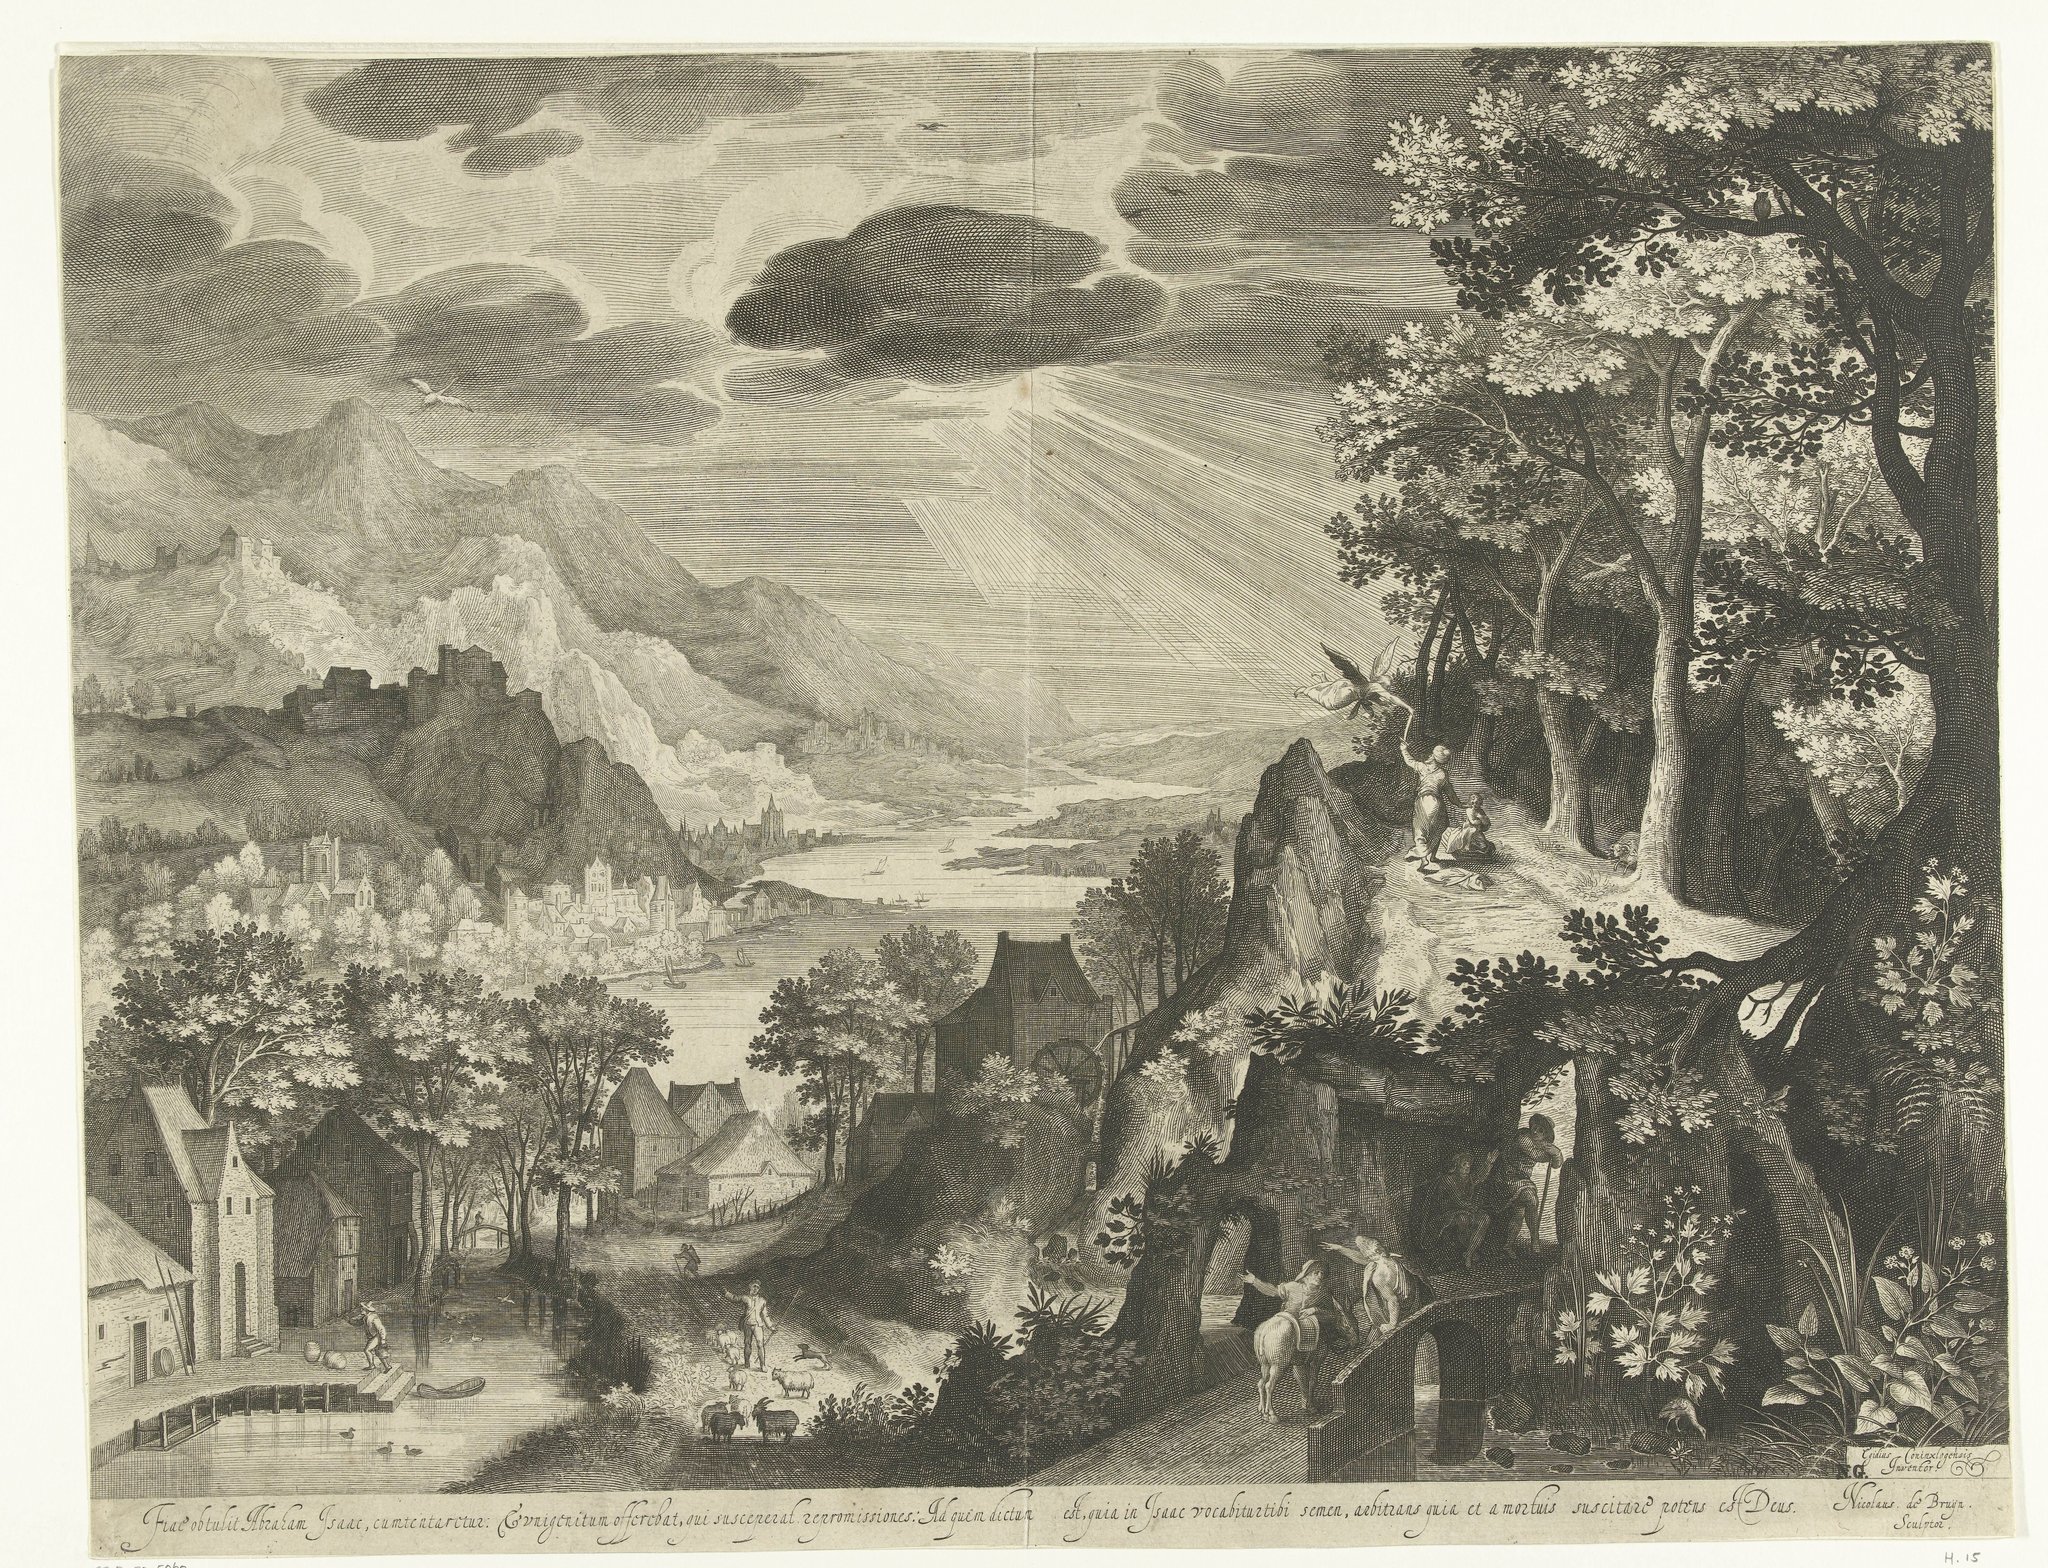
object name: print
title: Landschap met het offer van Abraham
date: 1581-1656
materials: paper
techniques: engraving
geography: netherlands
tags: when abraham has his hand raised to kill isaac, god or the hand of god restrains abraham's hand, mountains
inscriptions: collector's mark: Lugt 1967, collector's mark: Lugt 2228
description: Berglandschap met het offer van Abraham. Op een berg heft Abraham een zwaard om zijn zoon Isaak te doden maar een engel grijpt in. Onder de voorstelling staat een regel tekst in Latijn welke verwijst naar het bijbelverhaal.